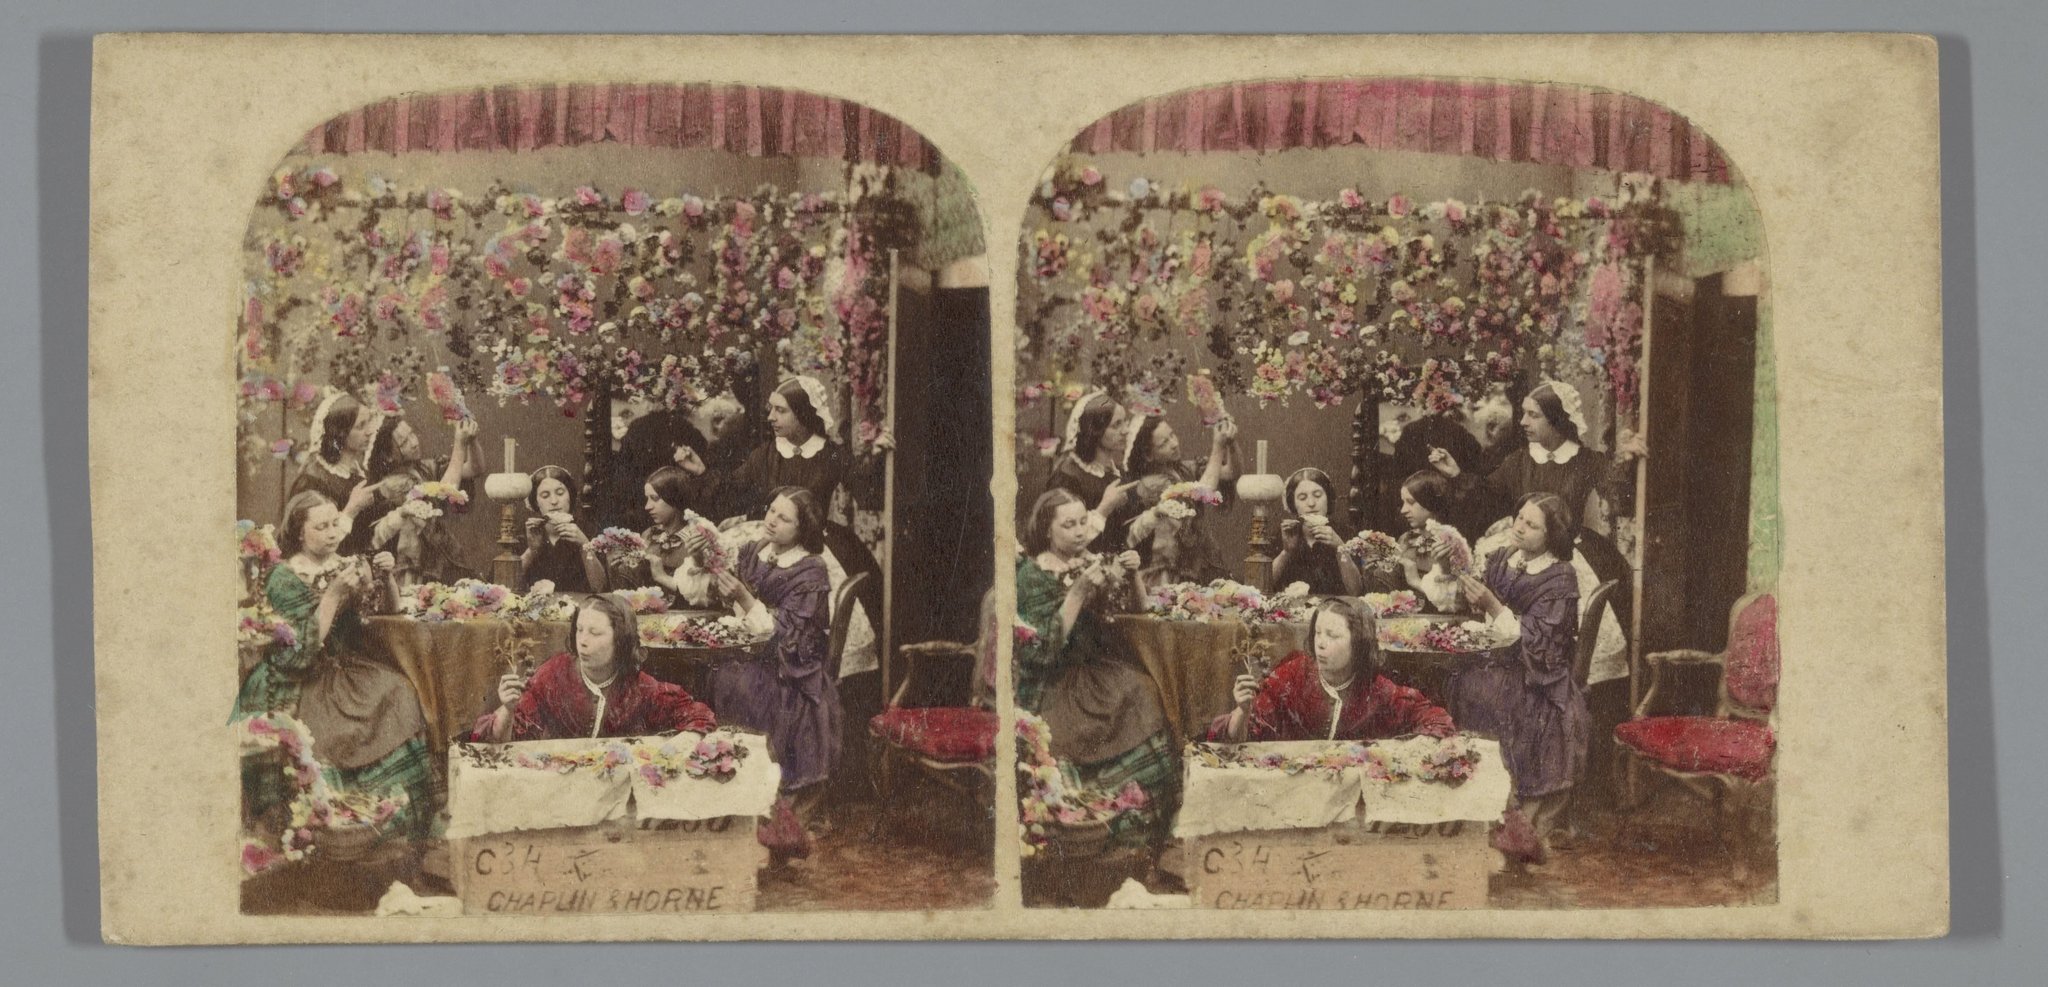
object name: stereograph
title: Artificial florist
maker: Anonymous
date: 1852-1863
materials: cardboard, paper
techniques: albumen print, hand coloring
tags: shop, store, flowers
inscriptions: inscription: ‘f [1].25’